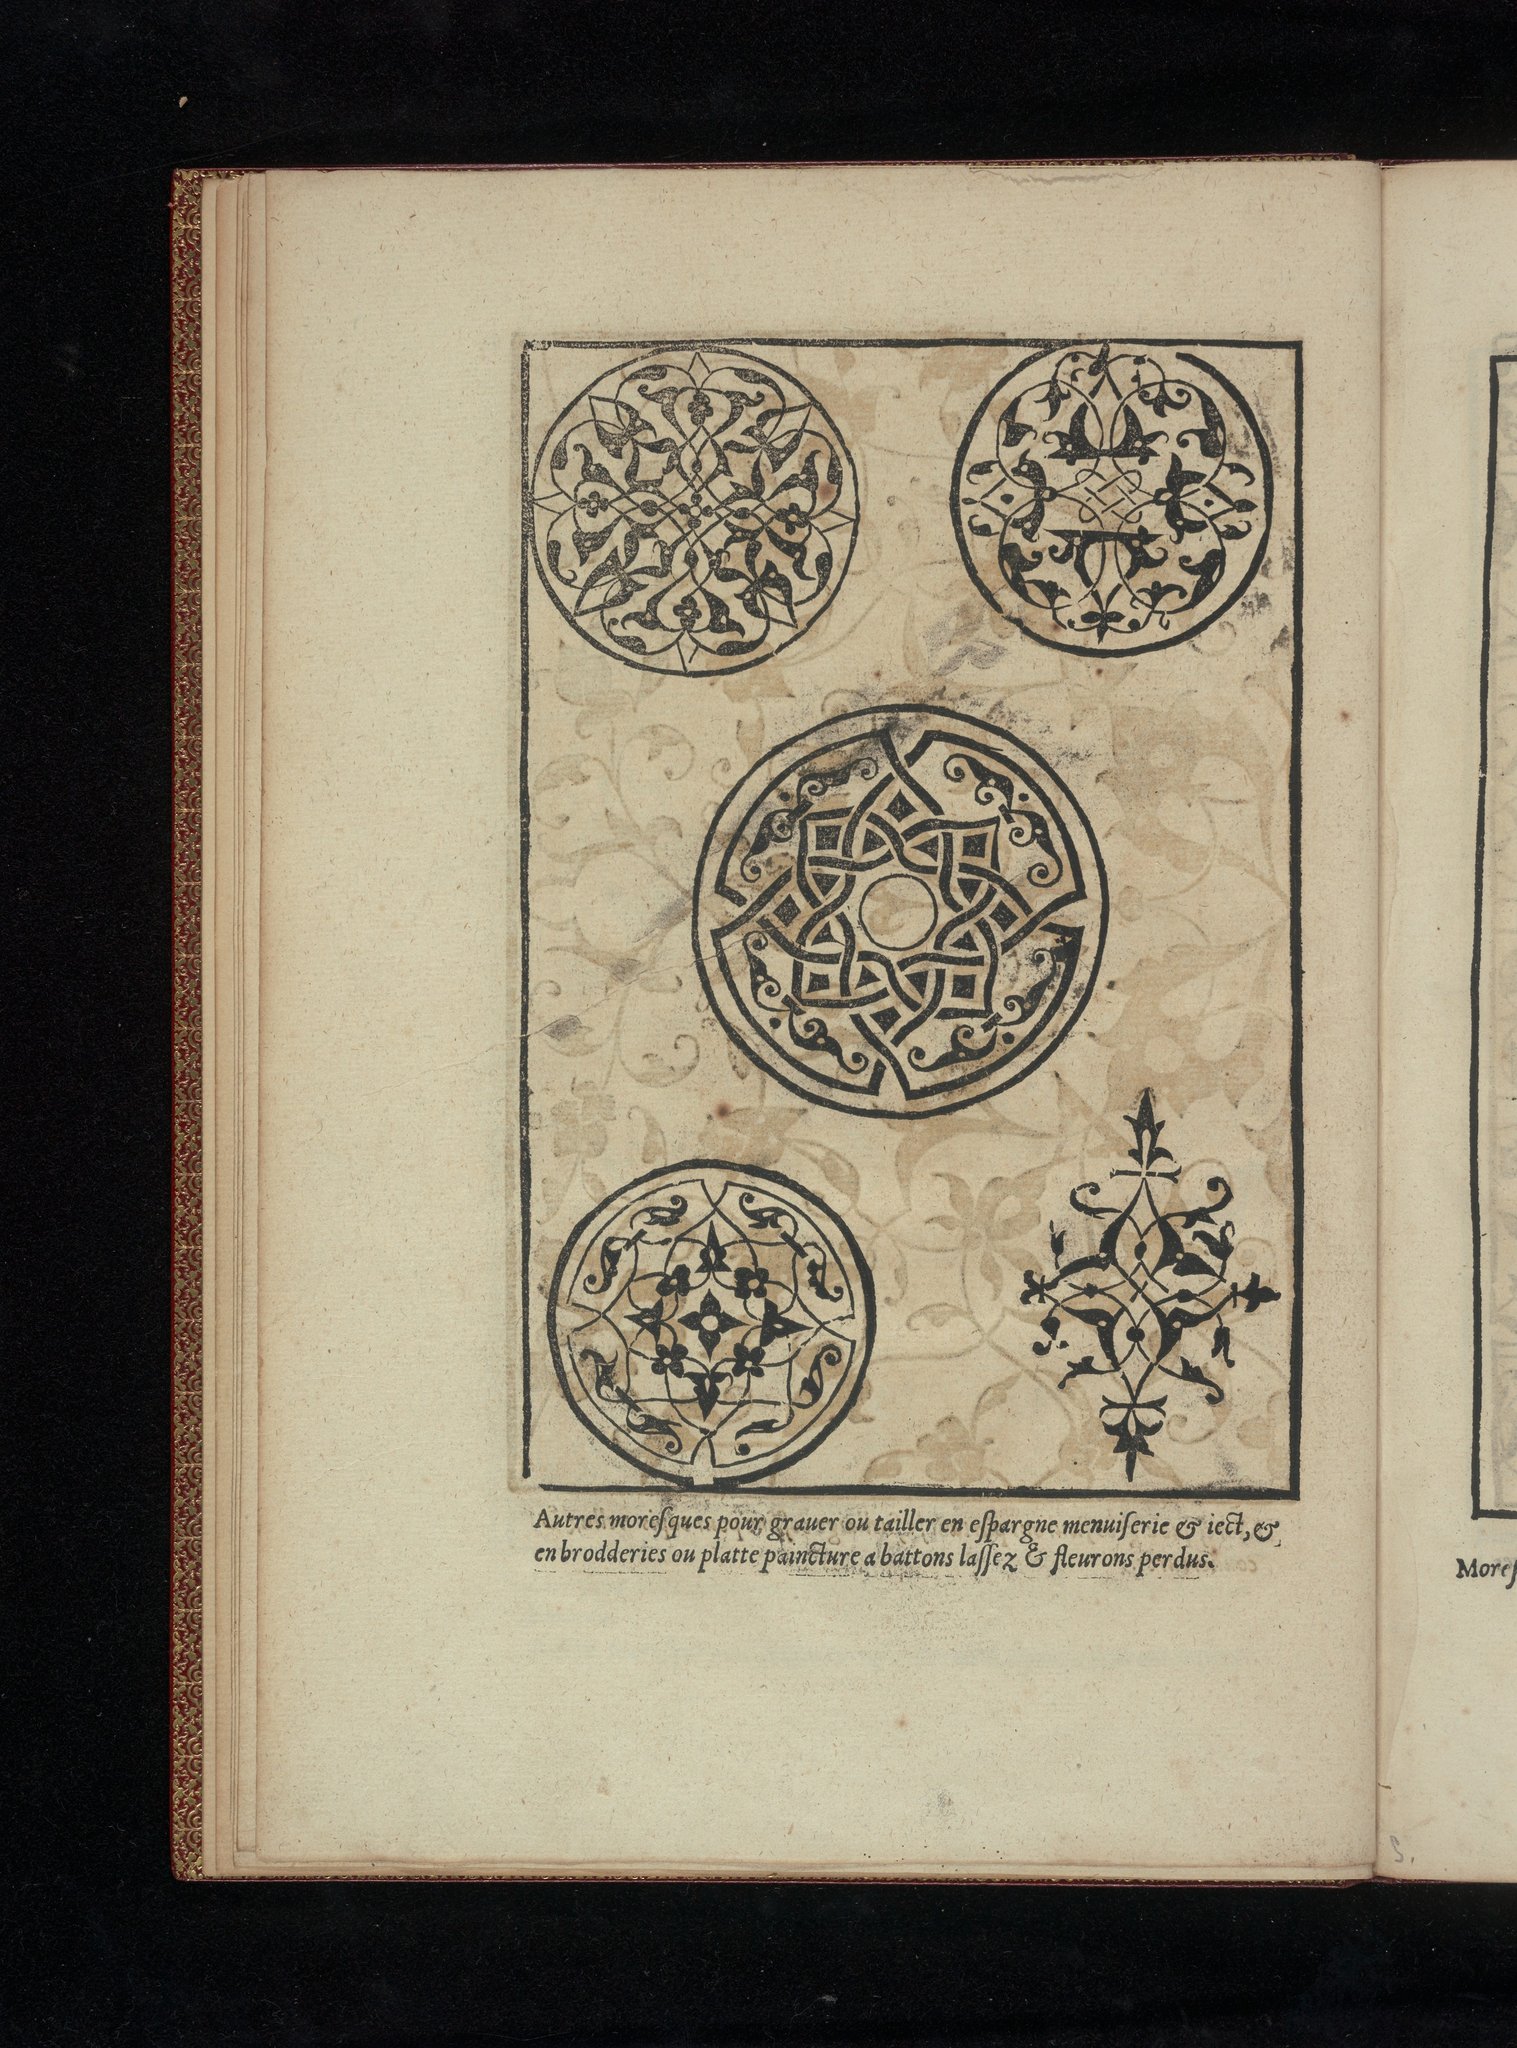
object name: book print ornament architecture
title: Livre de Moresques, page 3 (recto)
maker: francesco di pellegrino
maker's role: artist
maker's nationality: italian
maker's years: 1525-1552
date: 1546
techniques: woodcut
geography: france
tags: ornament